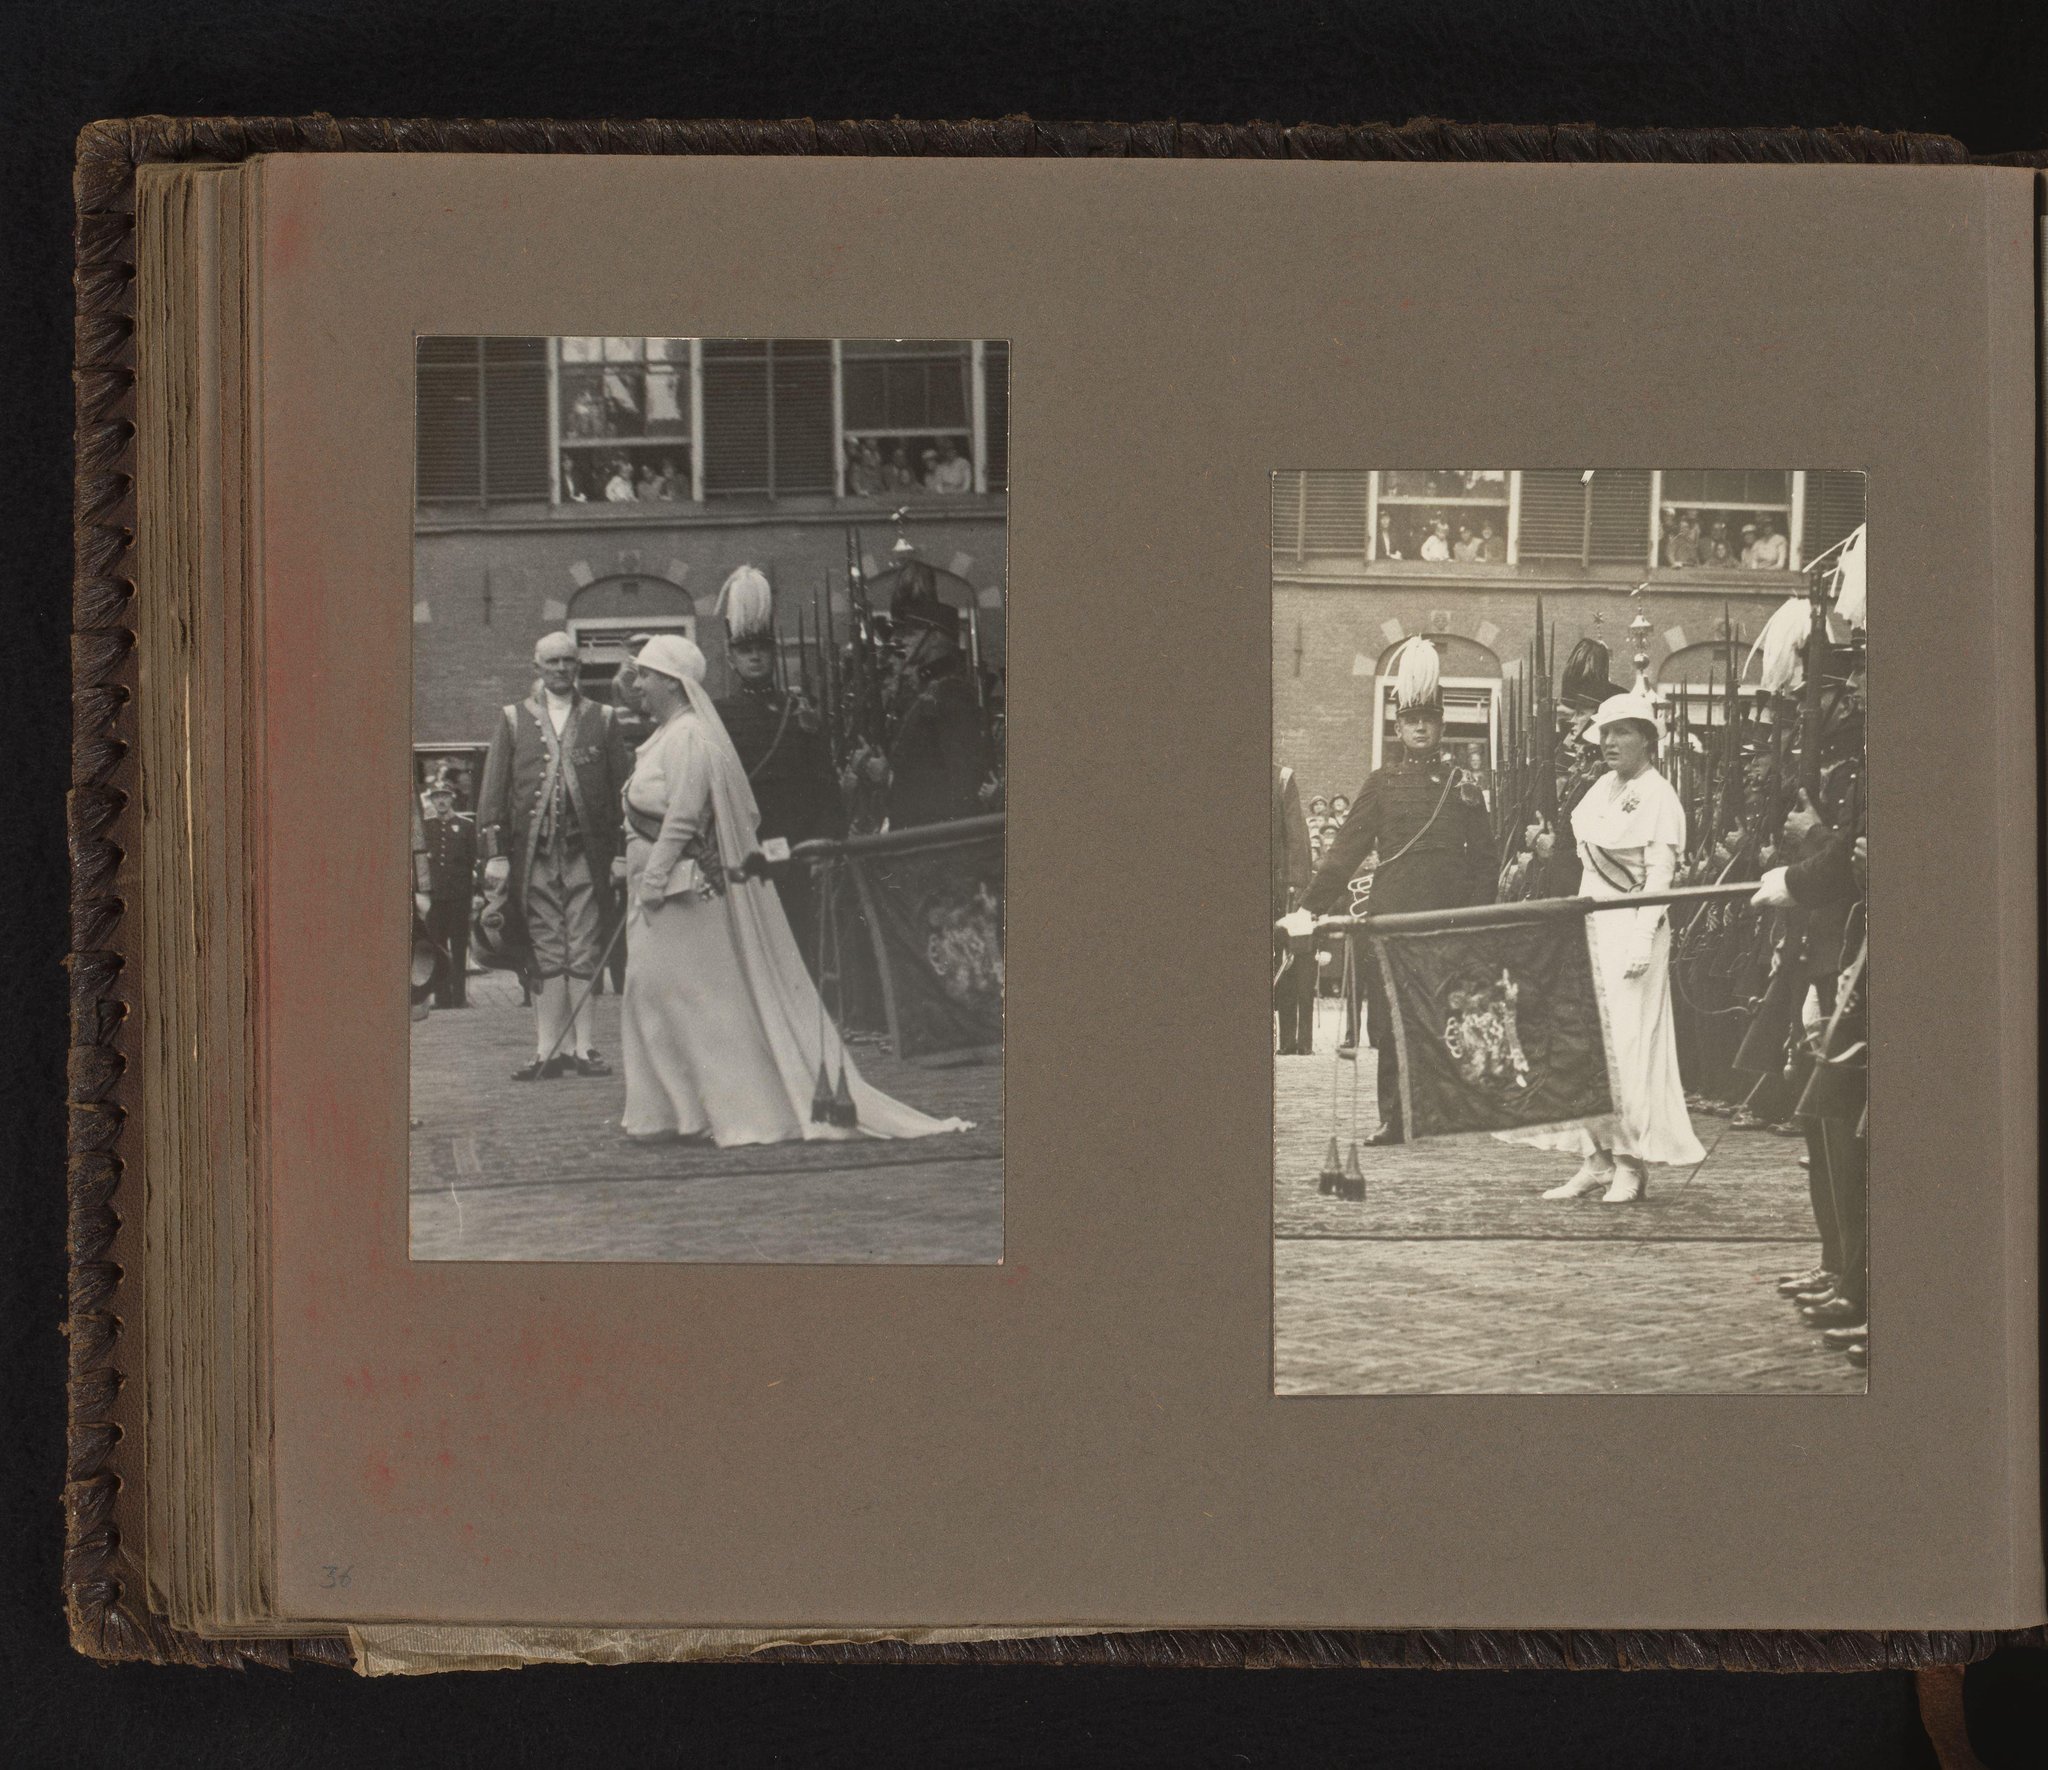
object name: album leaf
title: Twee foto's van koningin Wilhelmina en prinses Juliana op Prinsjesdag 1934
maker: Anonymous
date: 1934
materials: paper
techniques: gelatin silver print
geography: the hague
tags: print maker, wilhelmina of the netherlands, juliana of the netherlands, queen, princess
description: Deze foto's maken deel uit van een album.